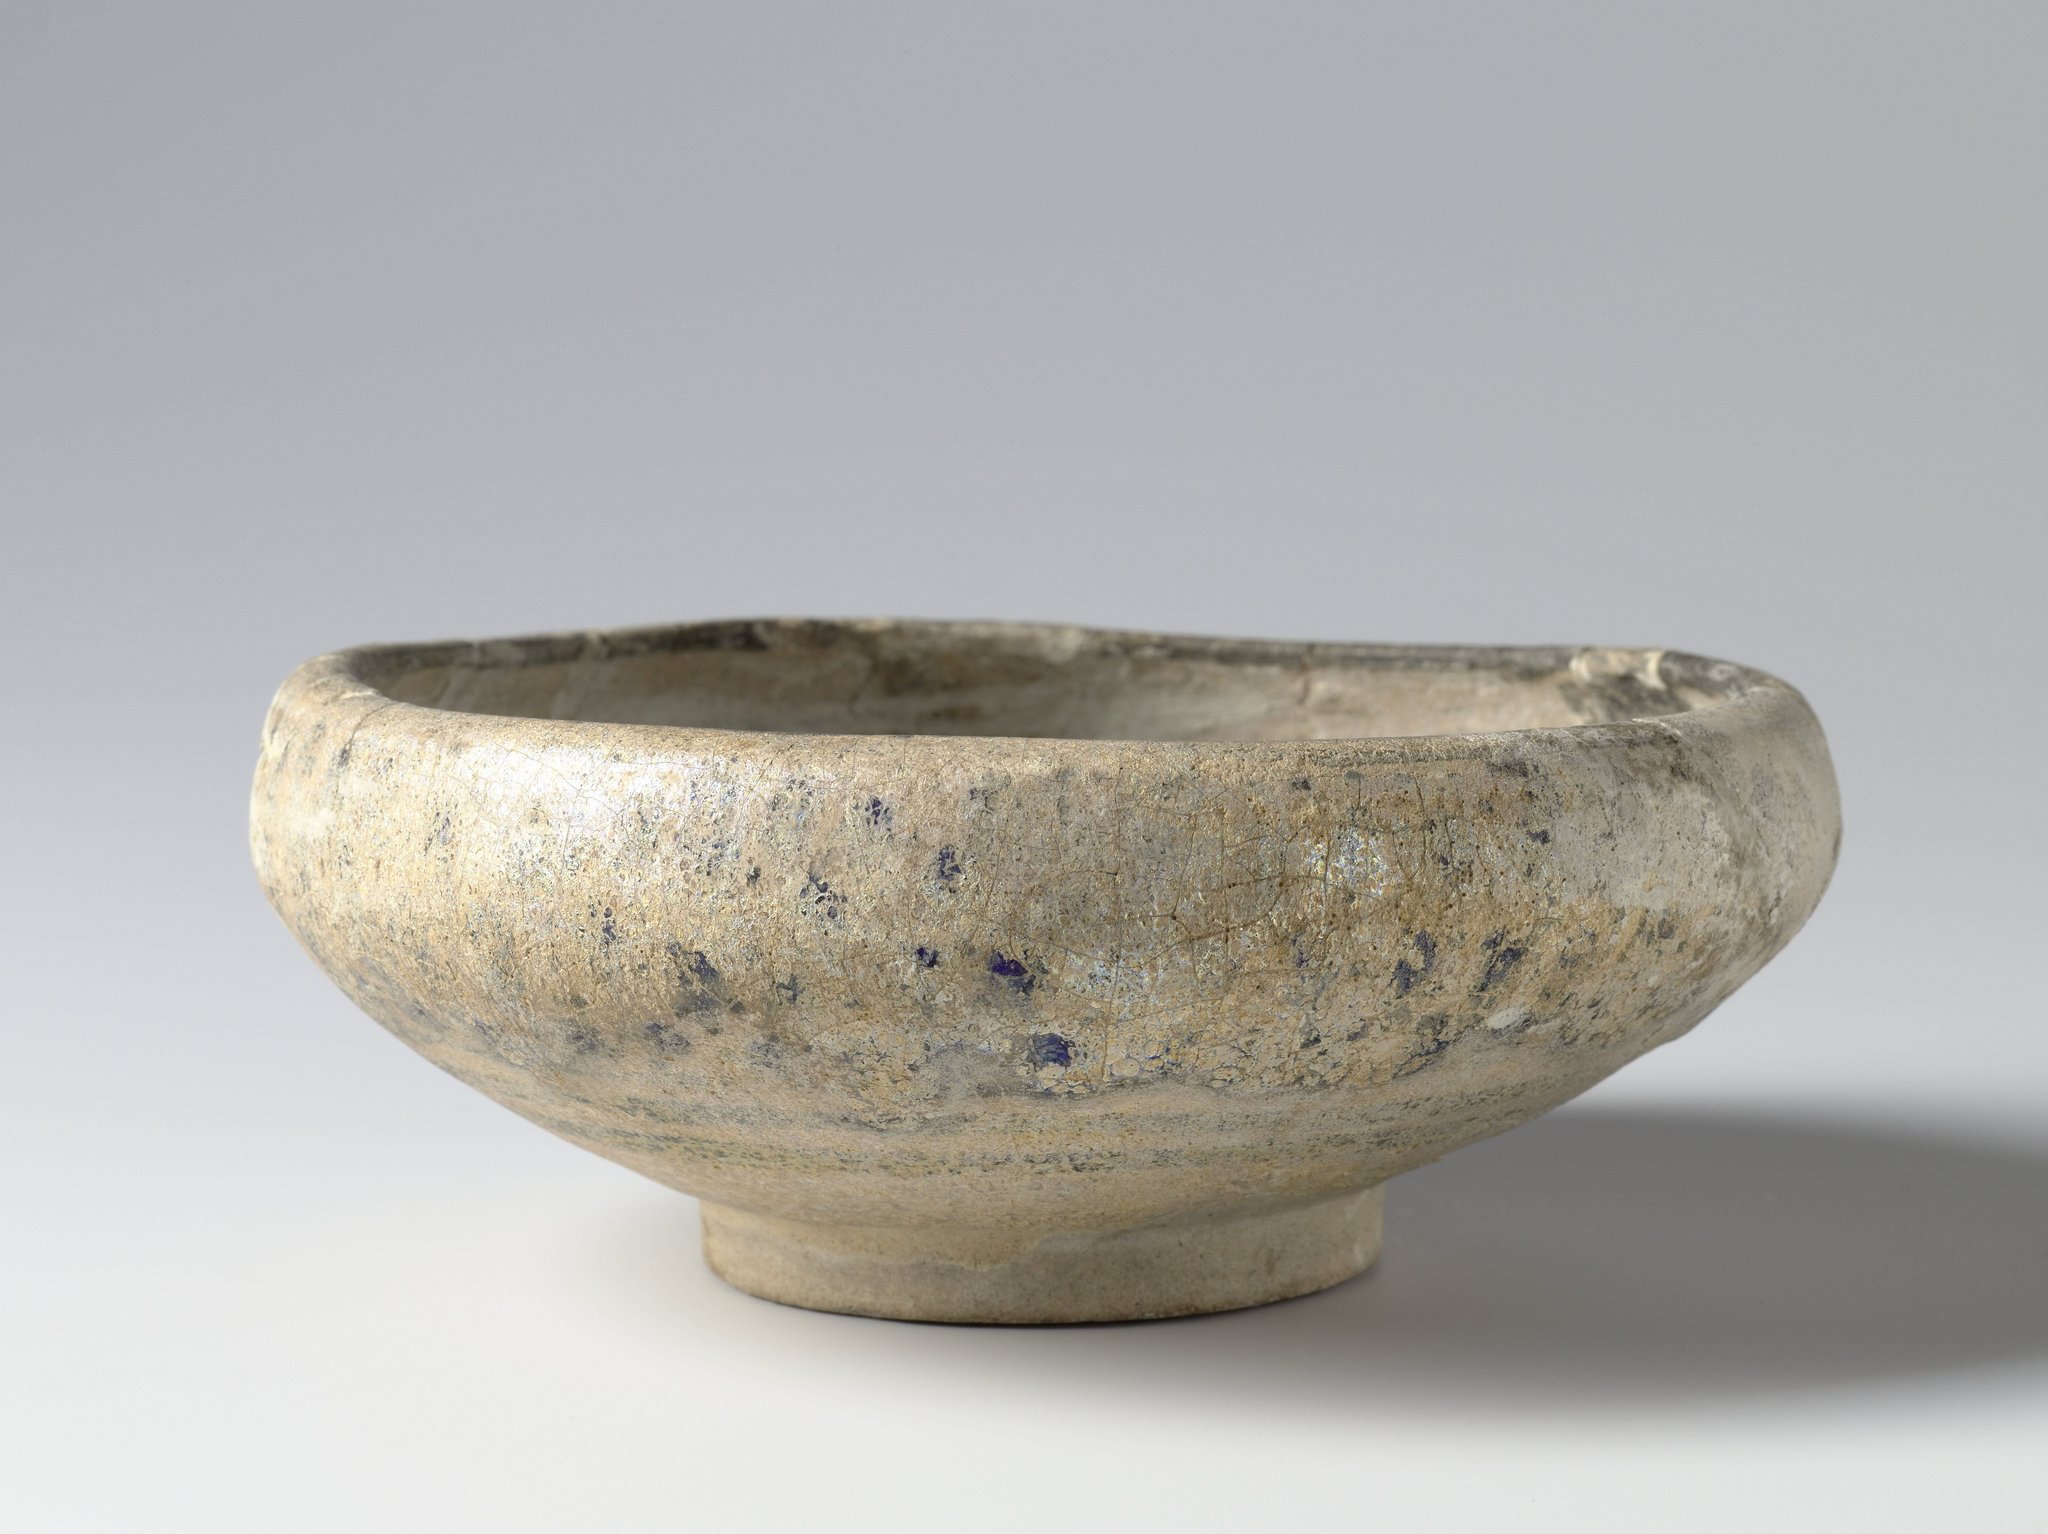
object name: bowl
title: Bowl with floral scrolls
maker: Anonymous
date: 1275-1324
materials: earthenware, glaze, paint, quartz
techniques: firing, turning, vitrification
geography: kashan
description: Kom van kwarts-fritgoed, gedecoreerd met bloemranken in slib-reliëf met turquoise en zwart onder een transparant alkaliglazuur.